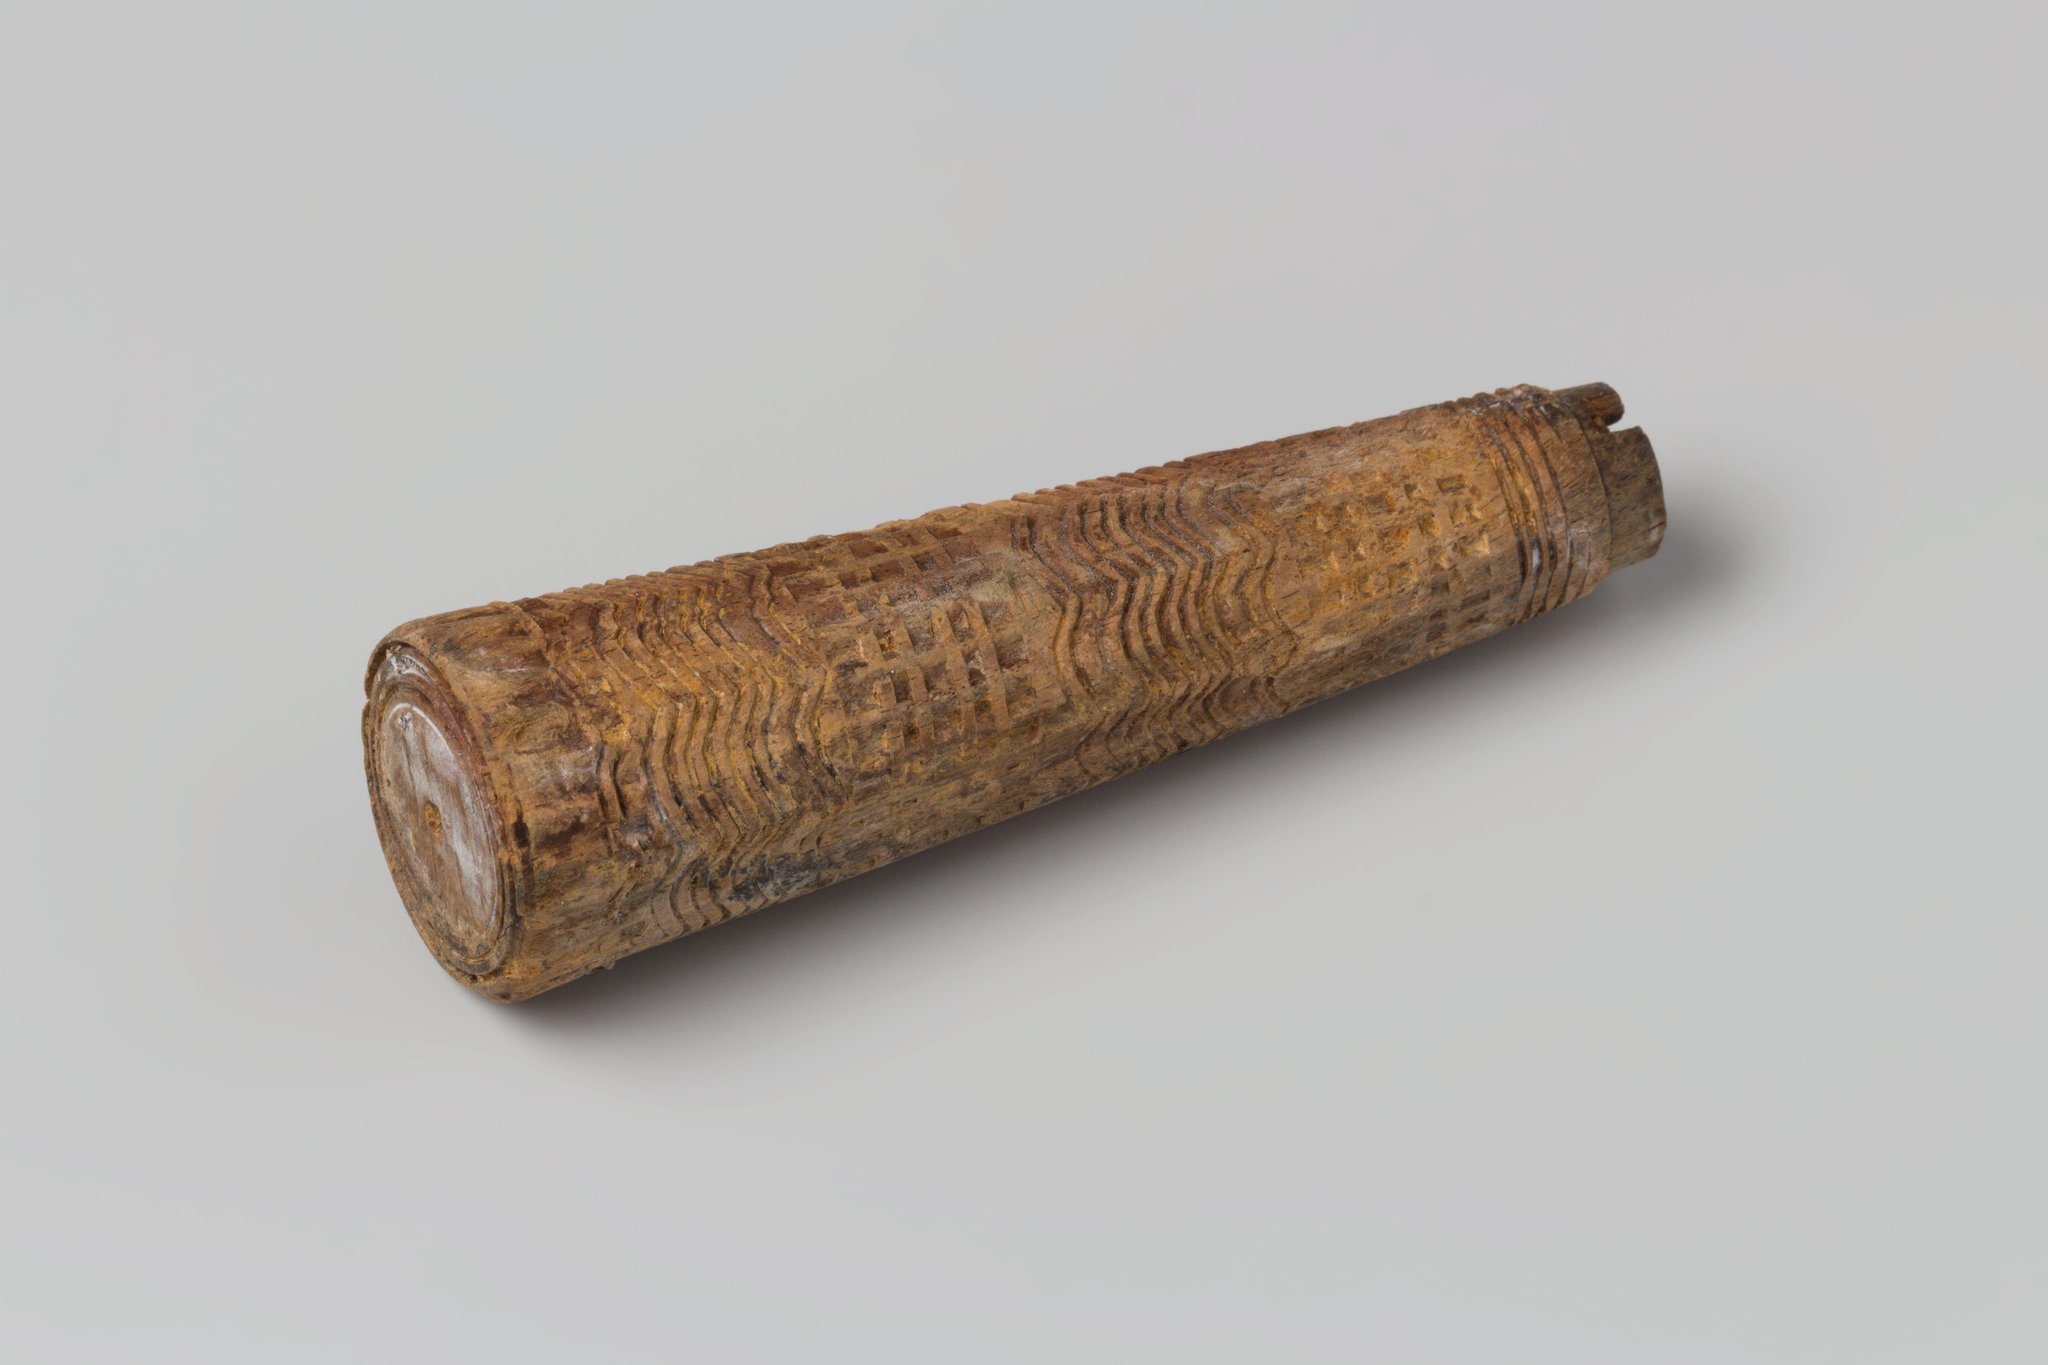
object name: knife handle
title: Messenheft uit het wrak van de Oost-Indiëvaarder Hollandia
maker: Anonymous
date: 1700-1743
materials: wood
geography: netherlands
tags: verenigde oostindische compagnie, hollandia (schip), annet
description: Knife, handle, cylindrical: tapering; id. NG 1979-403H.